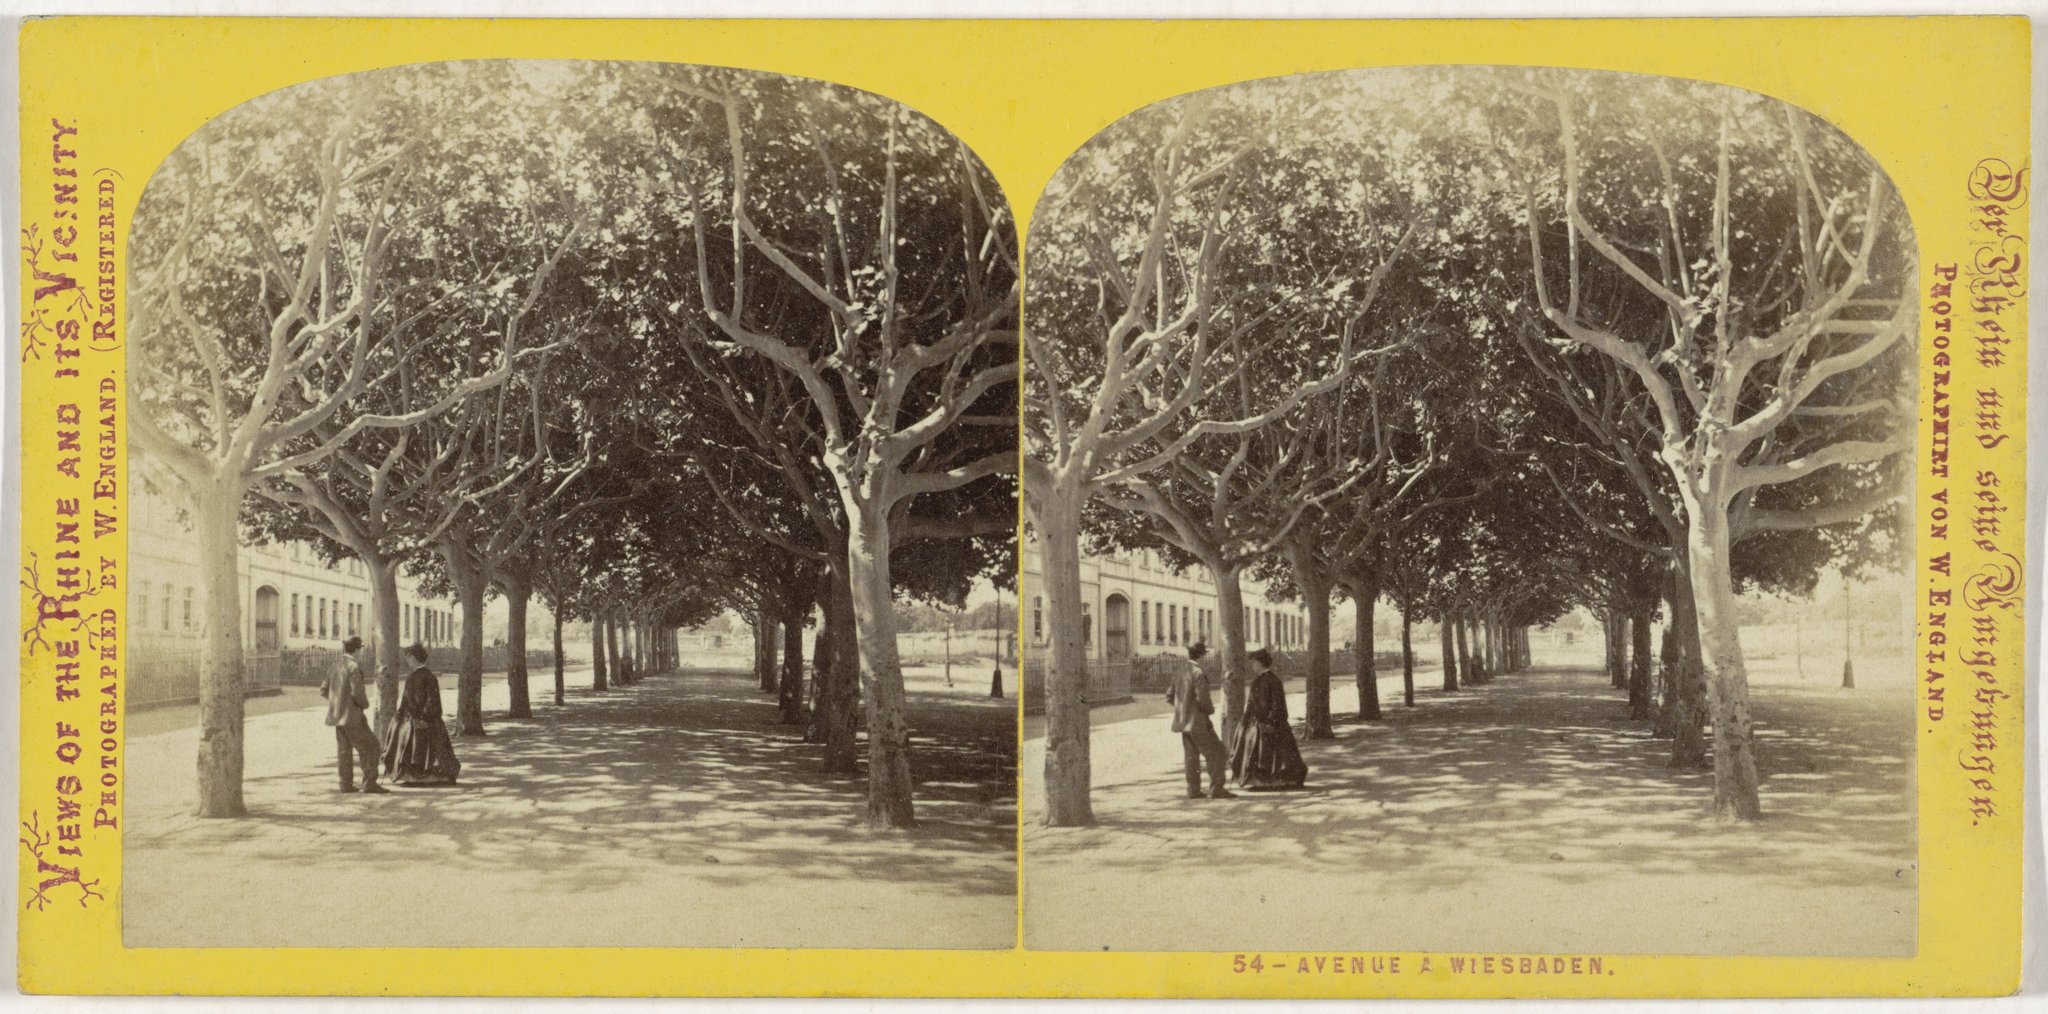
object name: stereograph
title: Wandelpromenade onder een rij bomen in Wiesbaden, Duitsland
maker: william england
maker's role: fotograaf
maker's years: 1816-1896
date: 1867-1868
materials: cardboard, paper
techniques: albumen print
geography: wiesbaden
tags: avenue, boulevard, promenade, esplanade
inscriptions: inscription: ‘(Registered)’, number: ‘54’